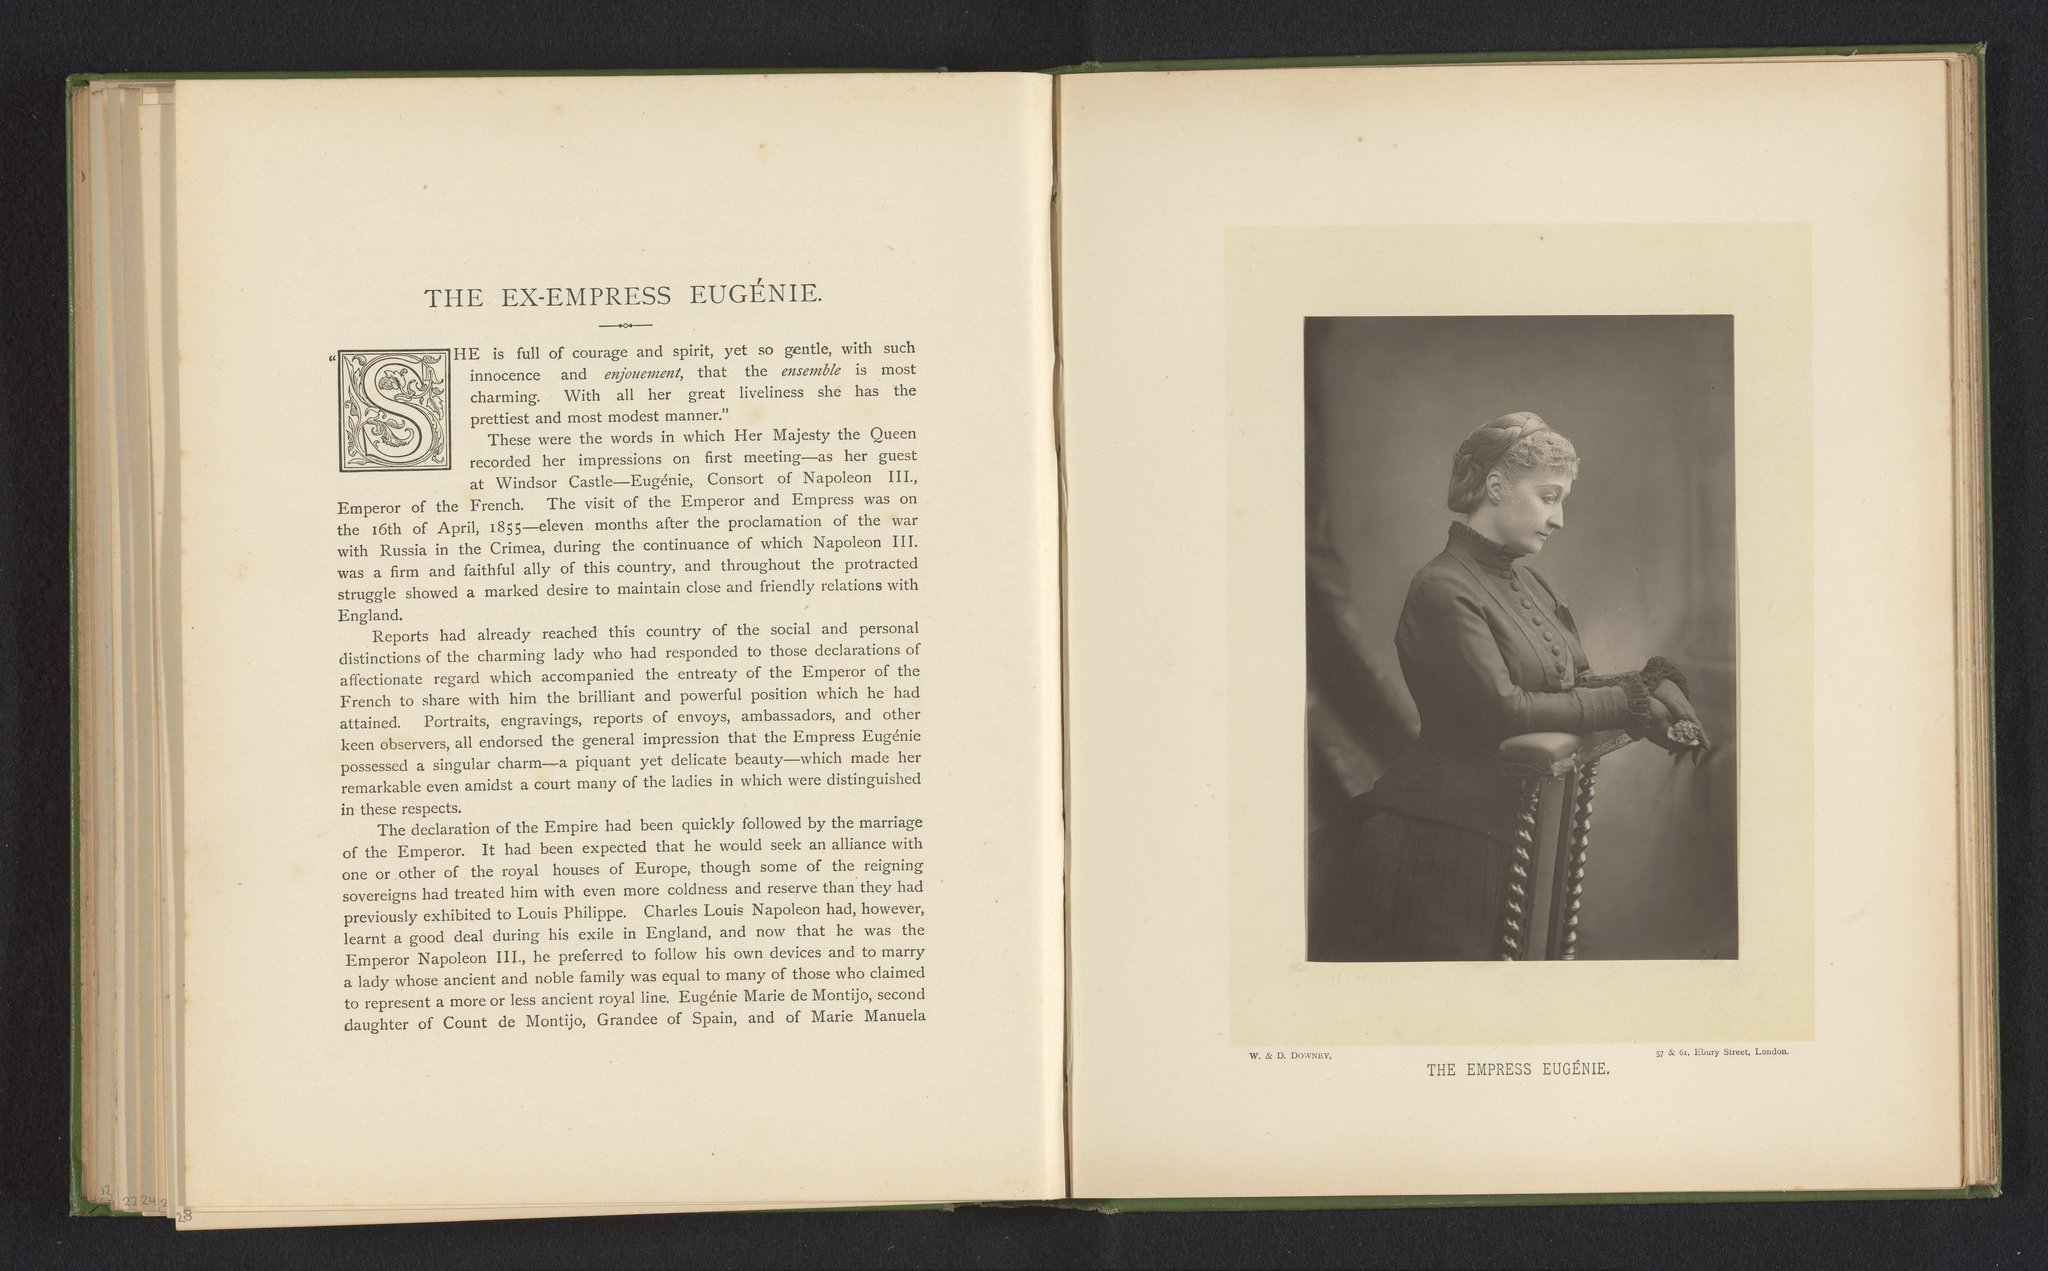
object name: photomechanical print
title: The empress Eugénie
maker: Anonymous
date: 1880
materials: paper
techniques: woodburytype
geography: london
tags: sevilla, ruler, sovereign - bb - female ruler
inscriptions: inscription: ‘57 & 61, Elbury Street, London.’